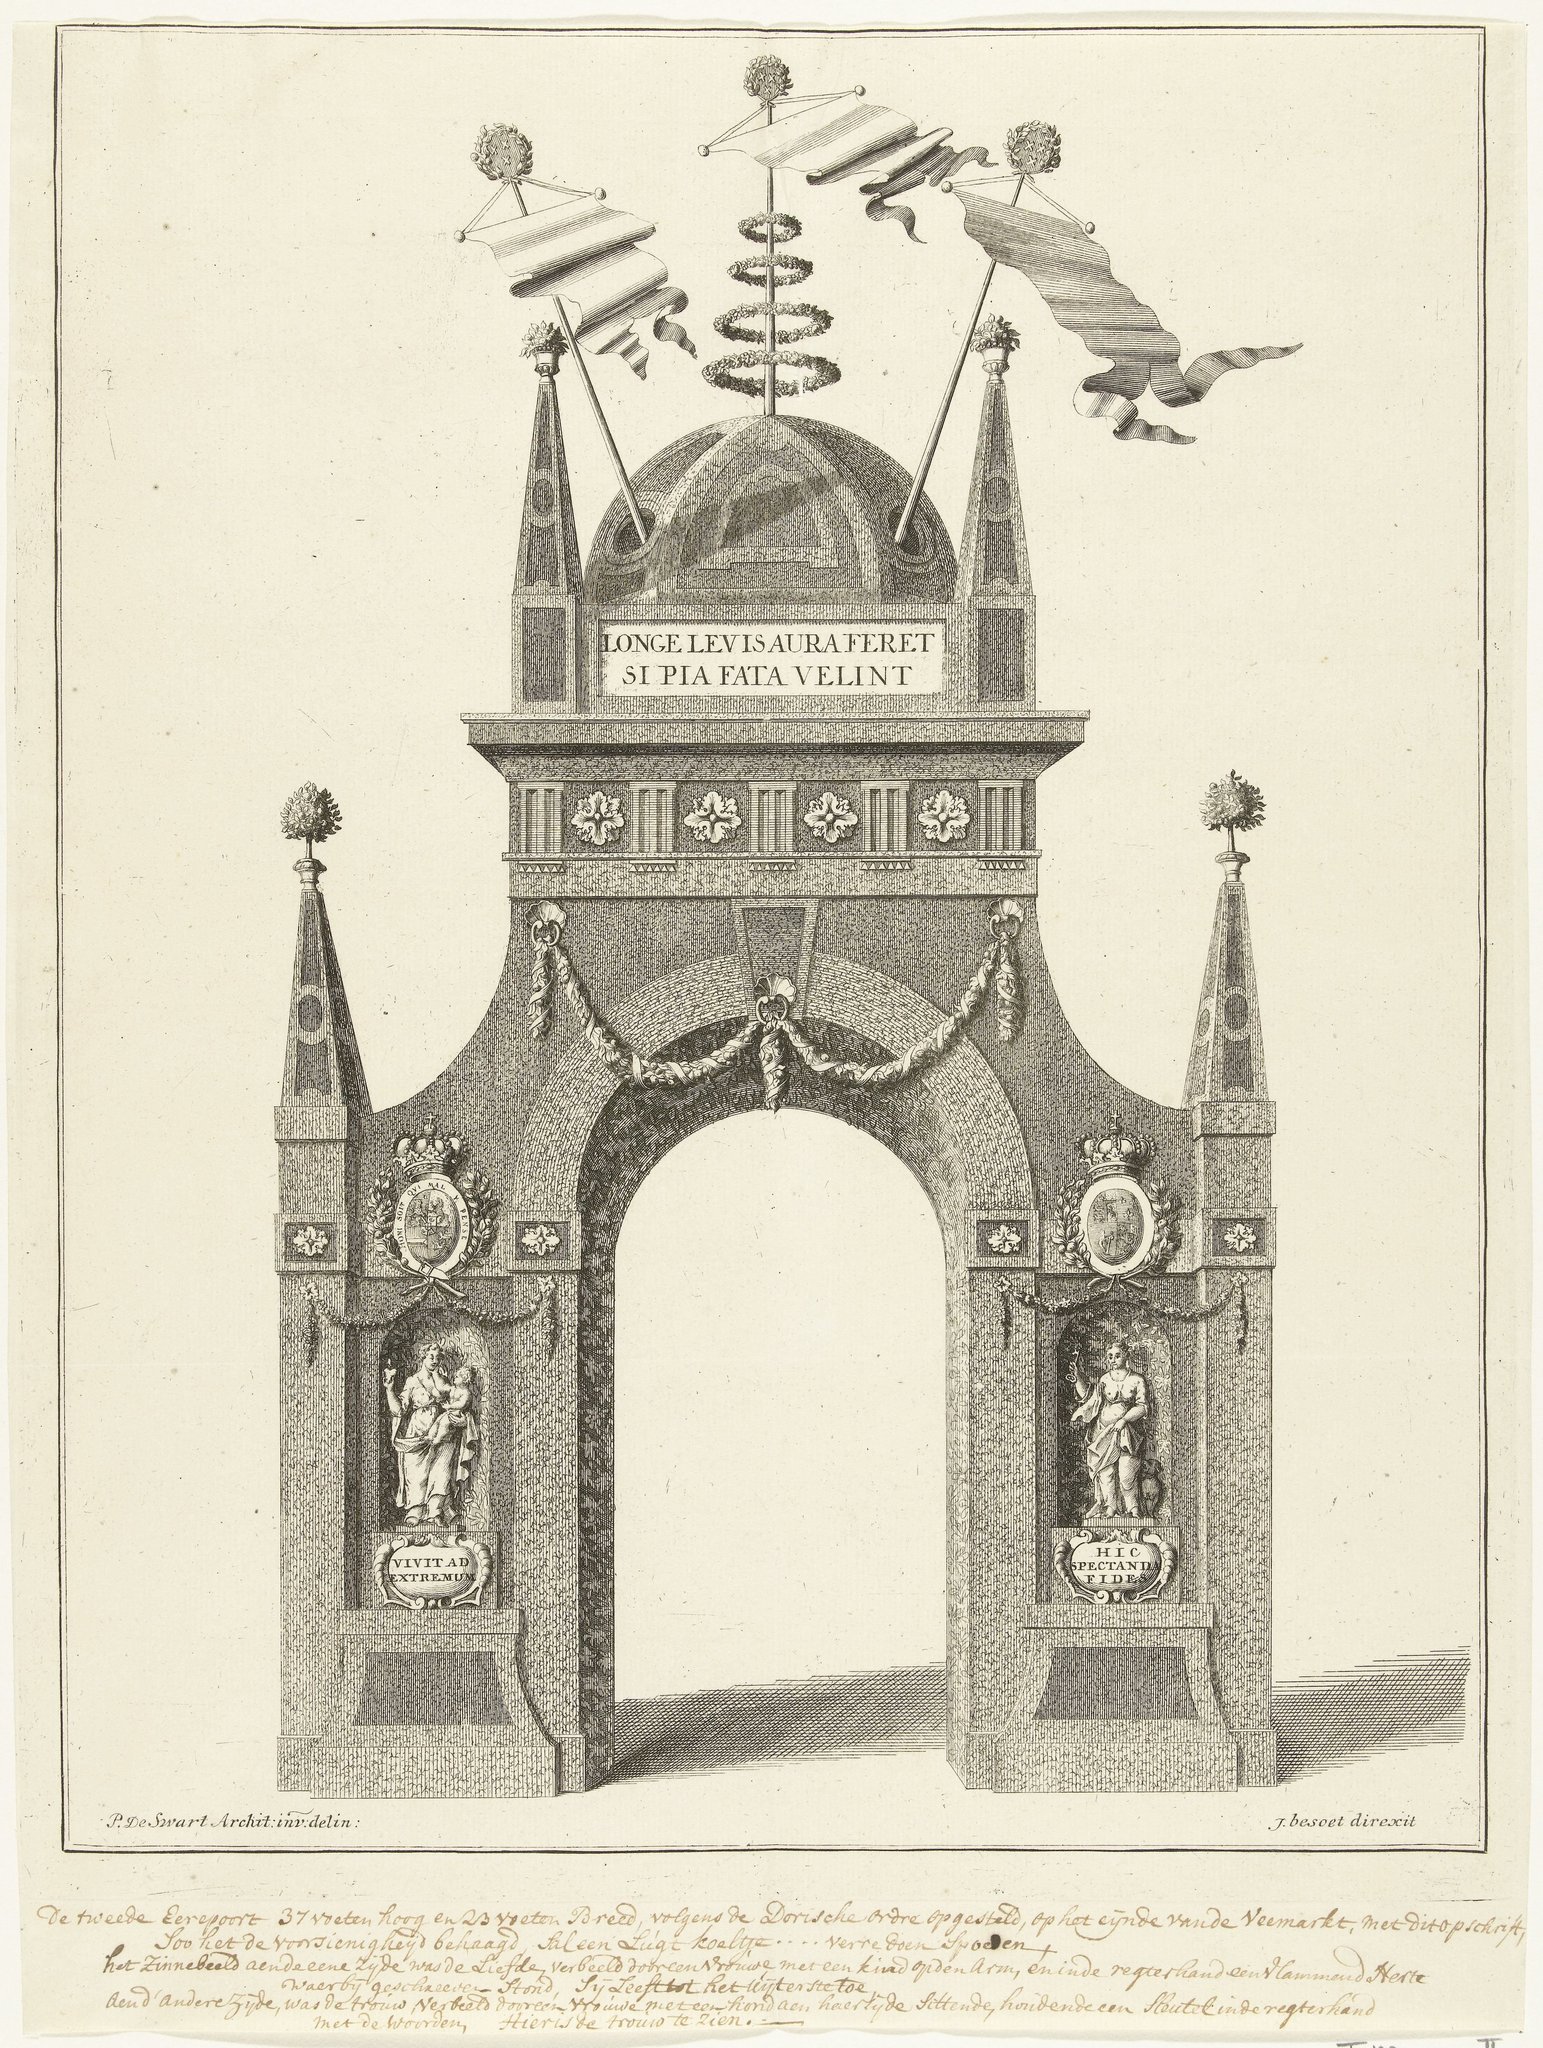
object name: print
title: Triomfpoort aan de Veemarkt bij de intrede van Willem IV te Breda, 1737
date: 1737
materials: paper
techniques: etching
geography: northern netherlands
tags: willem iv (prins van oranje-nassau), the hague, anna van hannover, triumphal arch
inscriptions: collector's mark: Lugt 2228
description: Gebruikt als illustratie in: Het blyde Breda ofte korte verhaal van de plegtige intrede van ... Willem Carel Hendrik Friso ... als Heer en Baron van Breda : ende H.K. Hoogheid Anna ... geschied op den XIII. van herfstmaand, 1737. 's-Gravenhage en Breda: Jacobus van den Kieboom & Johannnes van den Kieboom, 1737.